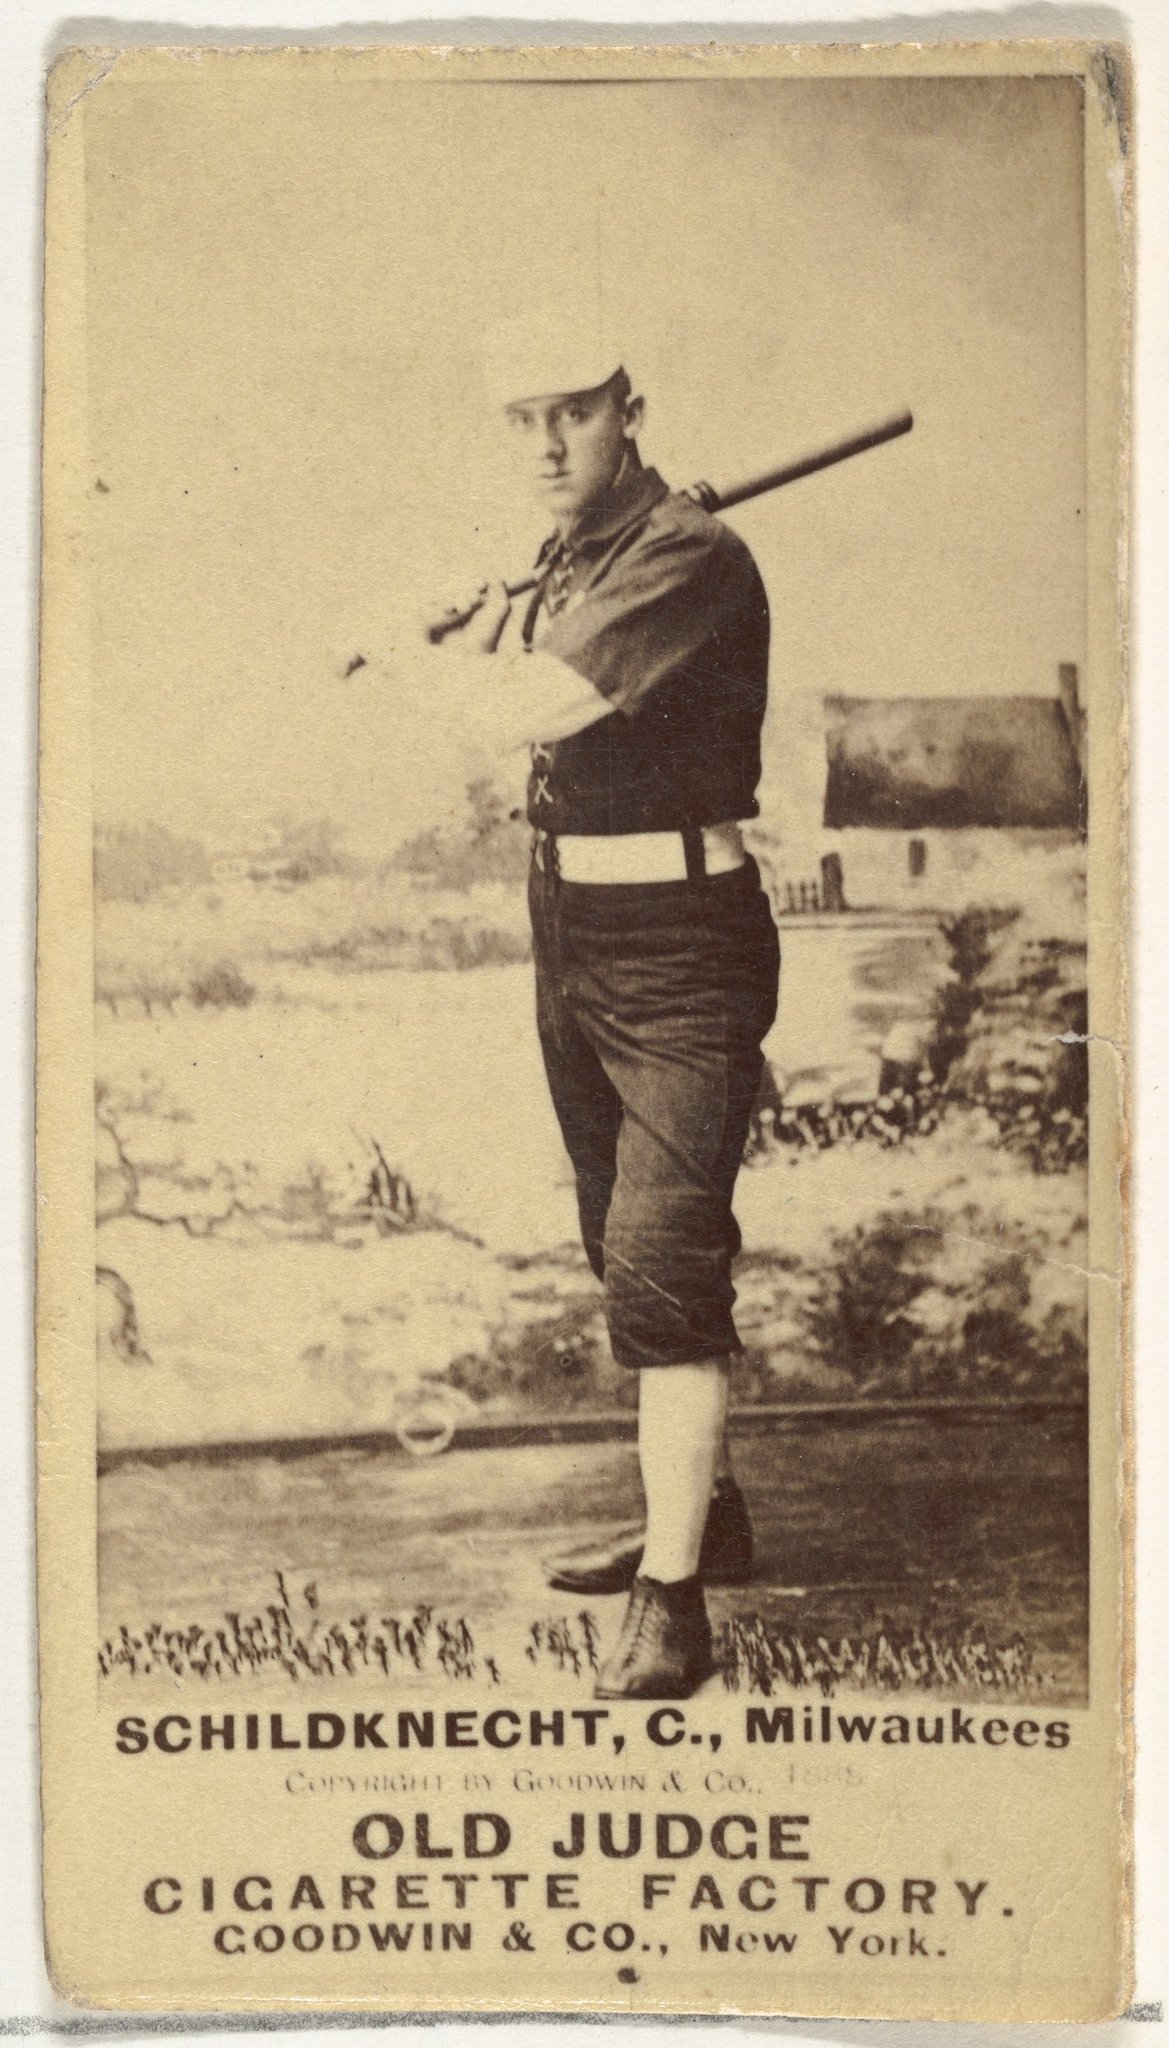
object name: baseball card, photograph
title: Schildknecht, Catcher, Milwaukee, from the Old Judge series (N172) for Old Judge Cigarettes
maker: goodwin & company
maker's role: publisher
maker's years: 1850-1950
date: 1888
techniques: albumen silver print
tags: men,portraits,baseball,athletes